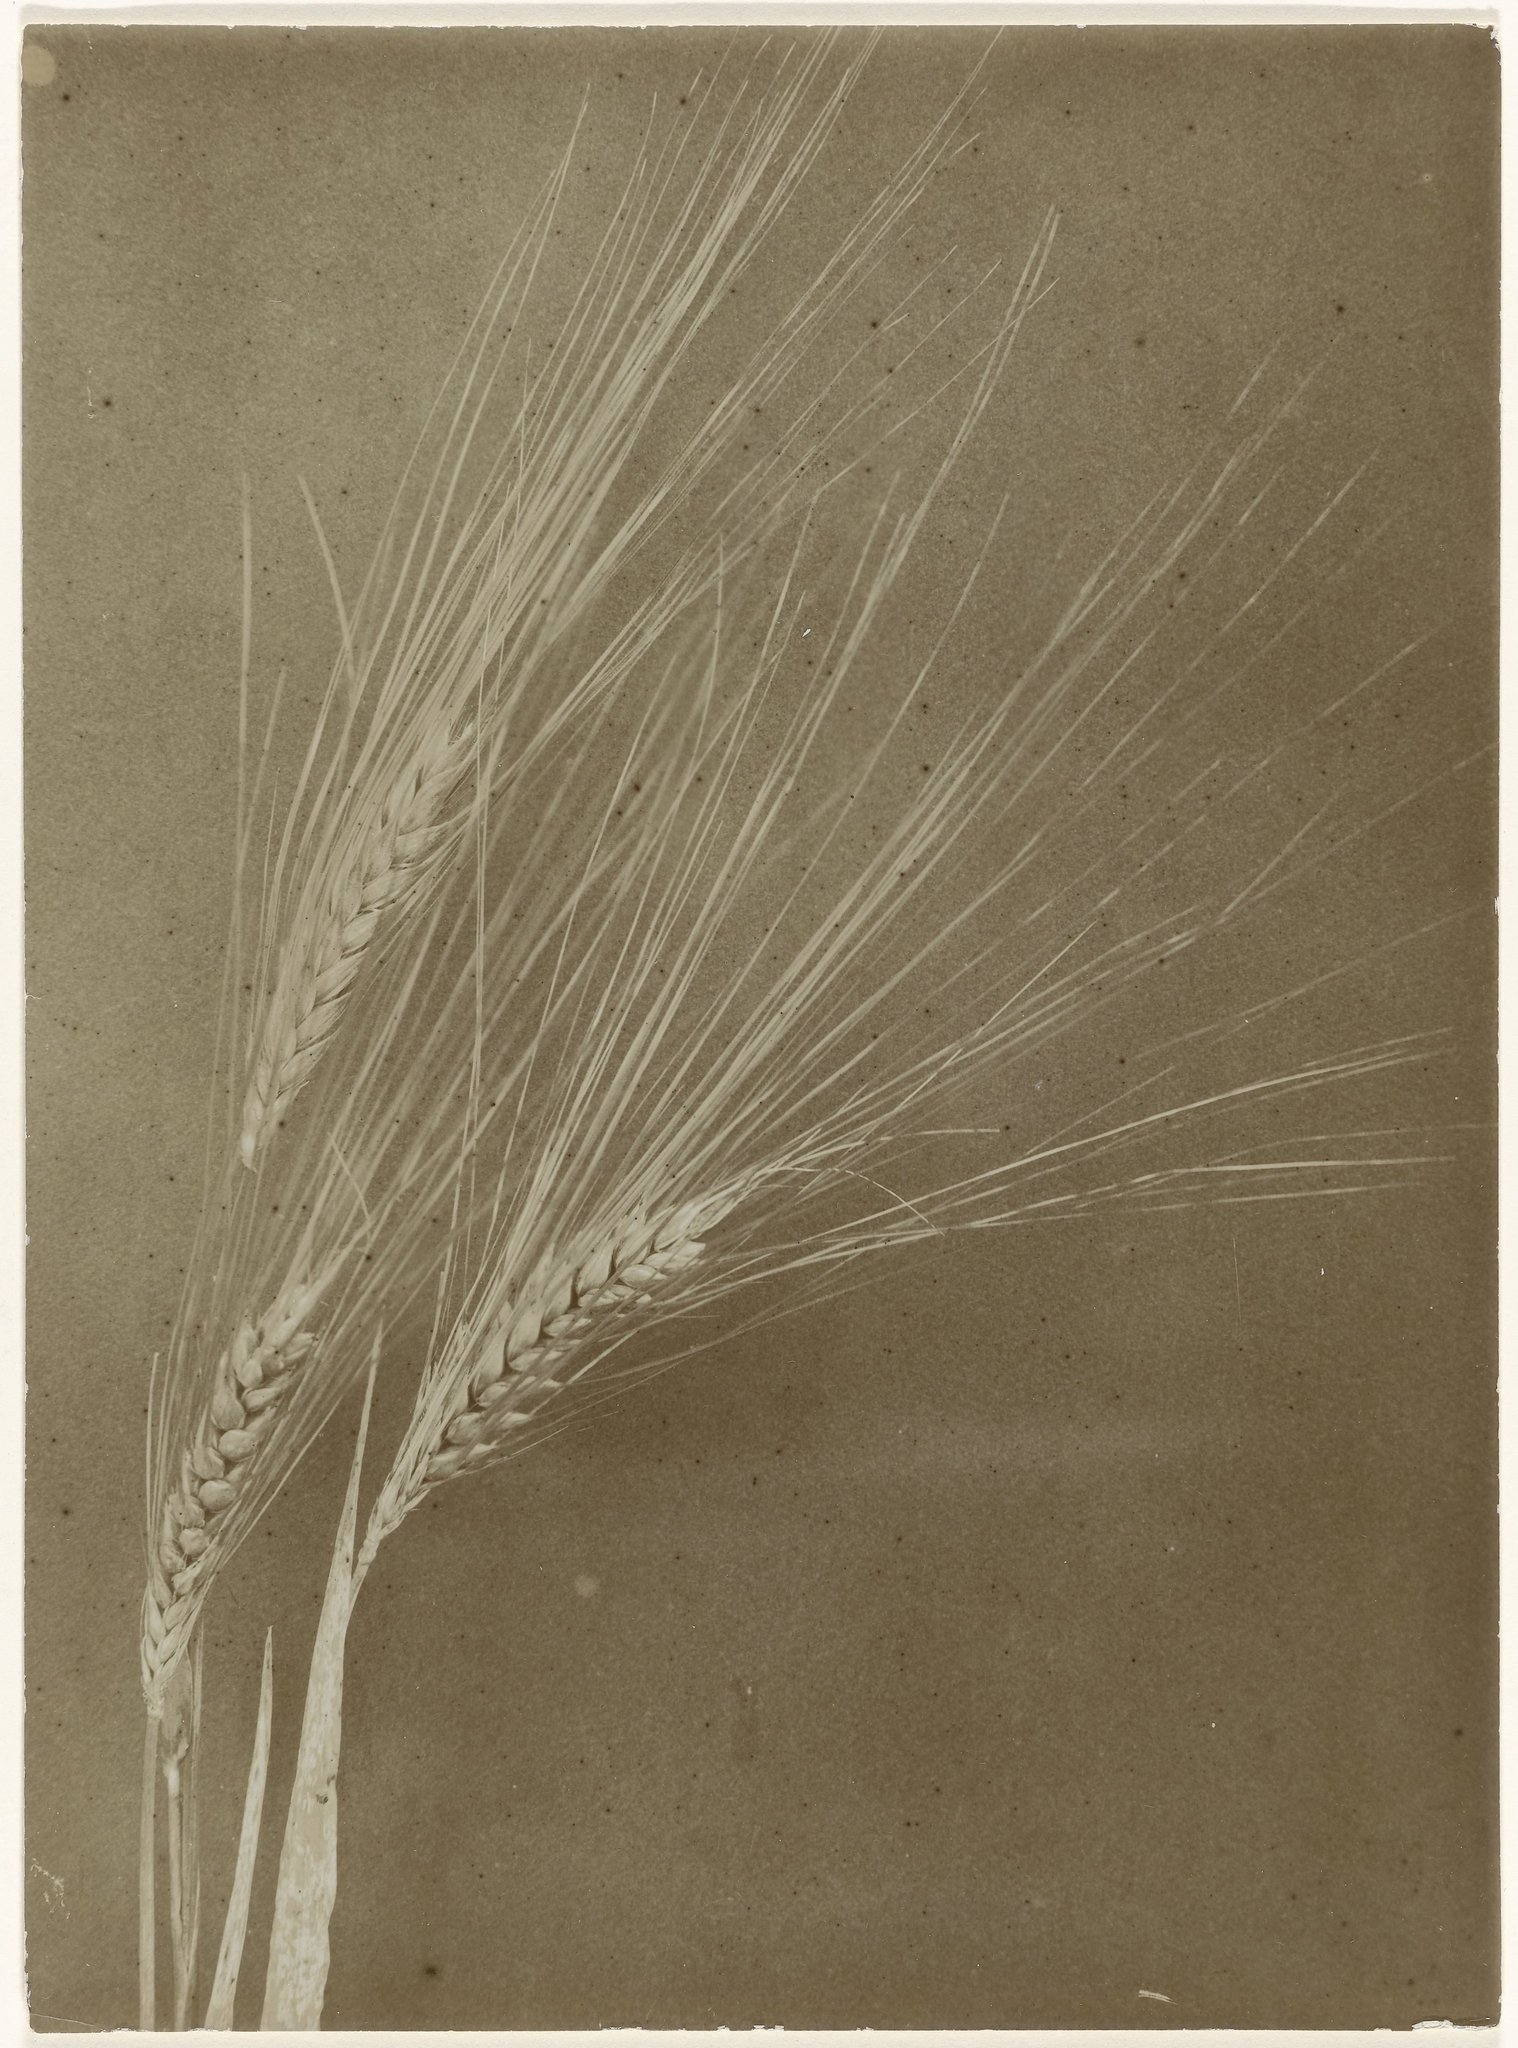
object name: photograph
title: Drie gerstaren tegen egale achtergrond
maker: richard tepe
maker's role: fotograaf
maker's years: 1864-1952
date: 1900-1940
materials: photographic support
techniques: gelatin silver print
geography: netherlands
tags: cereal, grain, corn (grass with grains, grown for food, e.g.: wheat, rice, rye, oats, maize, buckwheat, millet)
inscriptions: : ‘Gerst-Aren’, signature: ‘foto / R. Tepe’